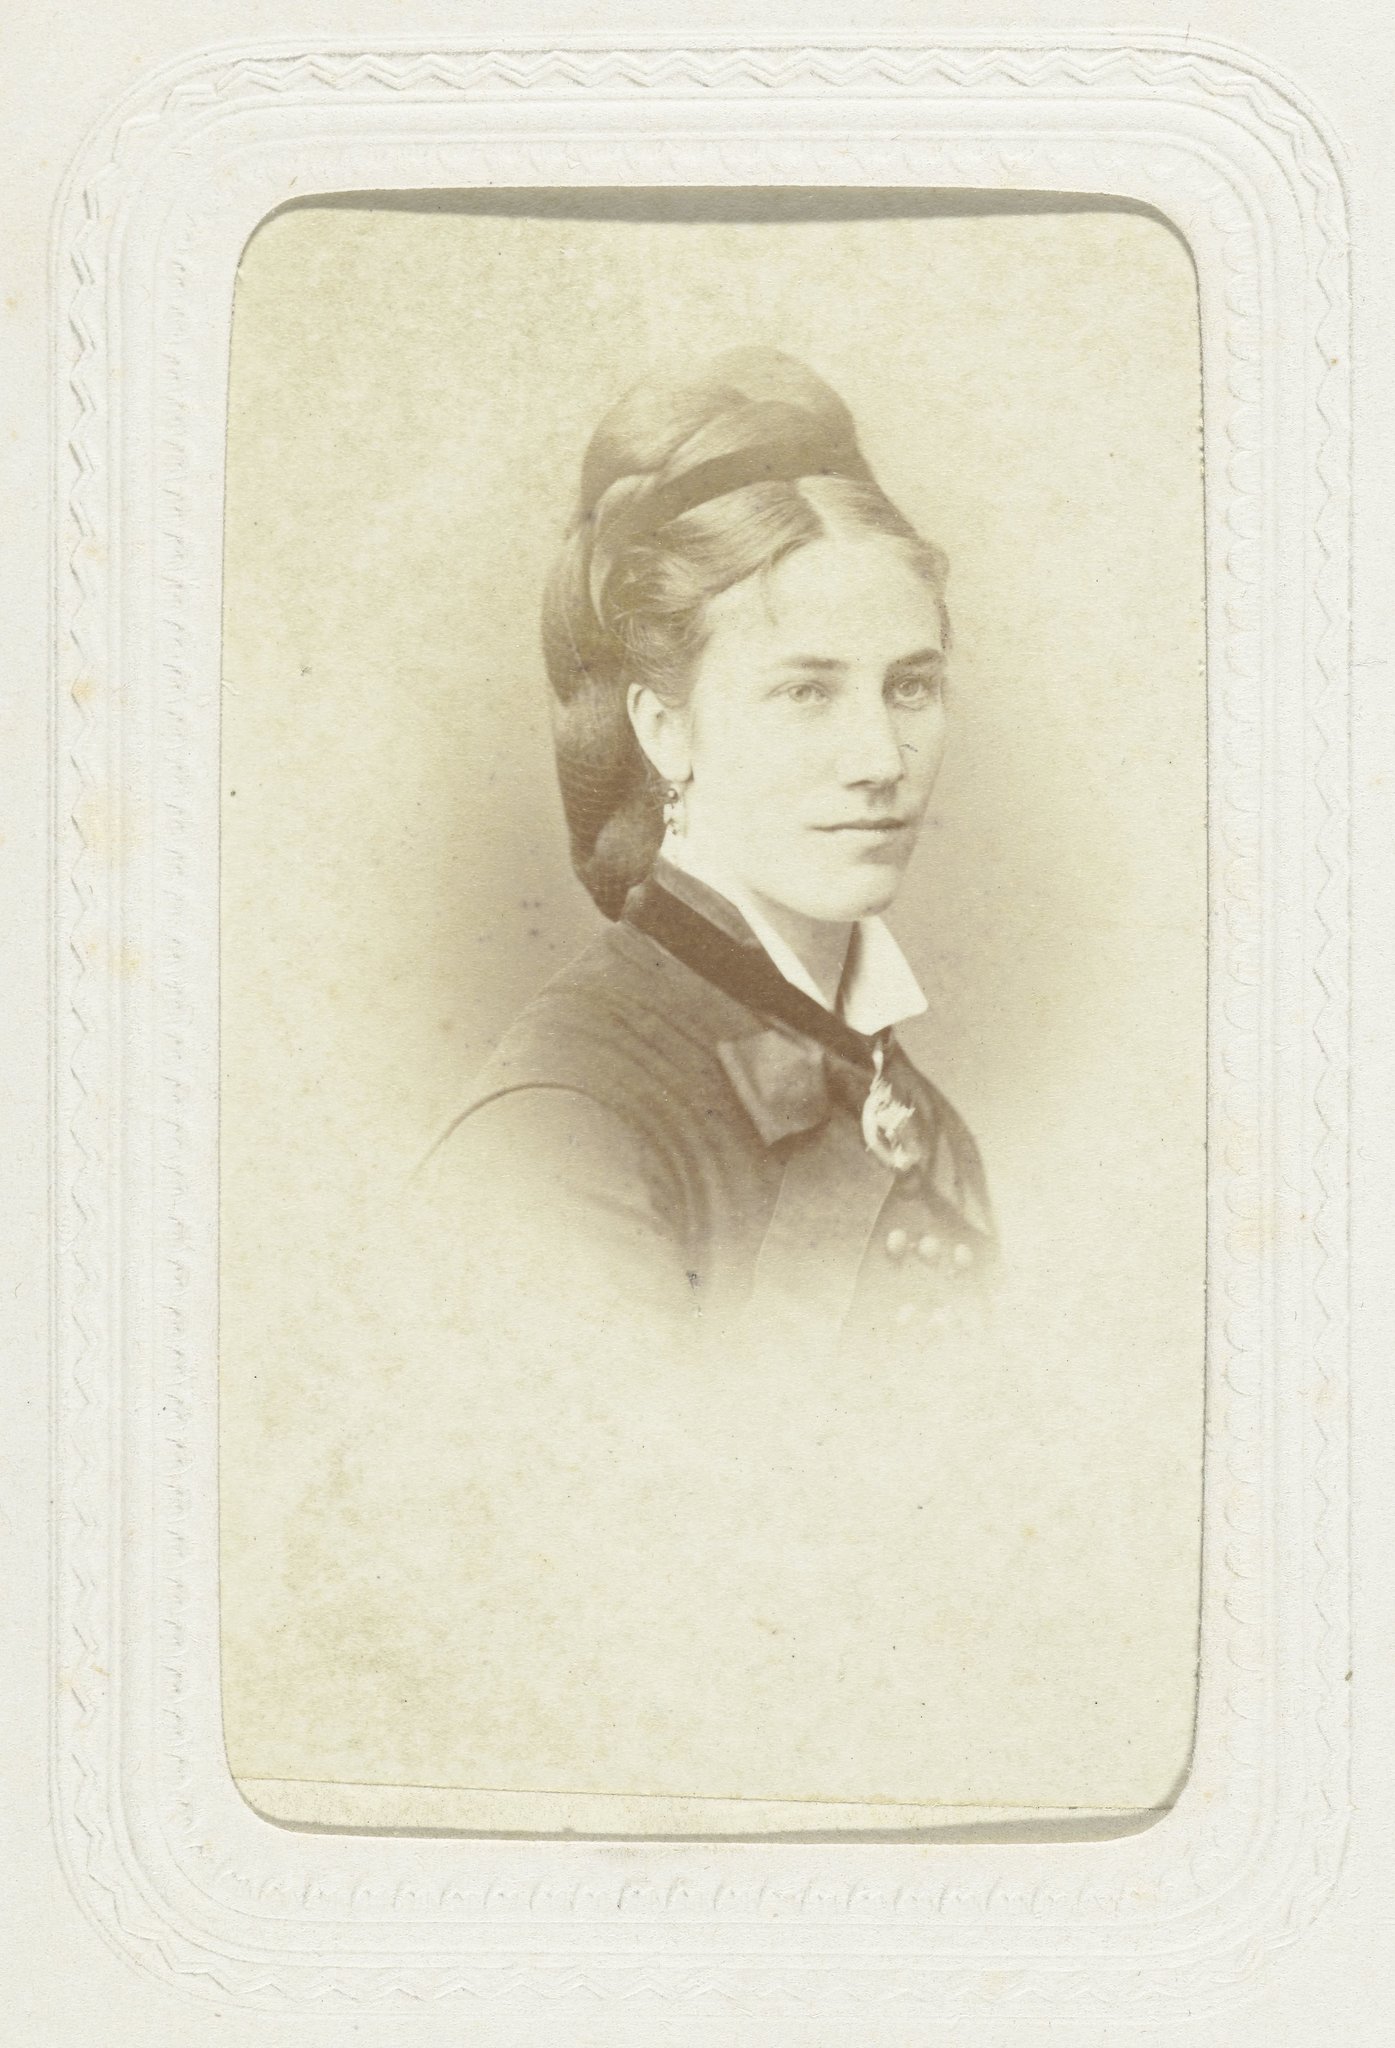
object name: carte de visite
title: Studioportret van een vrouw met gevlochten haar met een medaille of onderscheiding om haar nek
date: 1863-1866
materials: cardboard, paper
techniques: albumen print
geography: amsterdam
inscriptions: name: ‘Wegner & Mottu, Amsterdam’